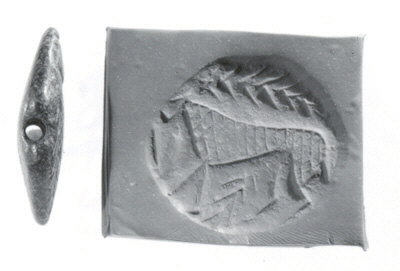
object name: stamp seal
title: Carinated lentoid seal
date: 4500-3600 BCE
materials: mineral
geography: northern syria or eastern anatolia